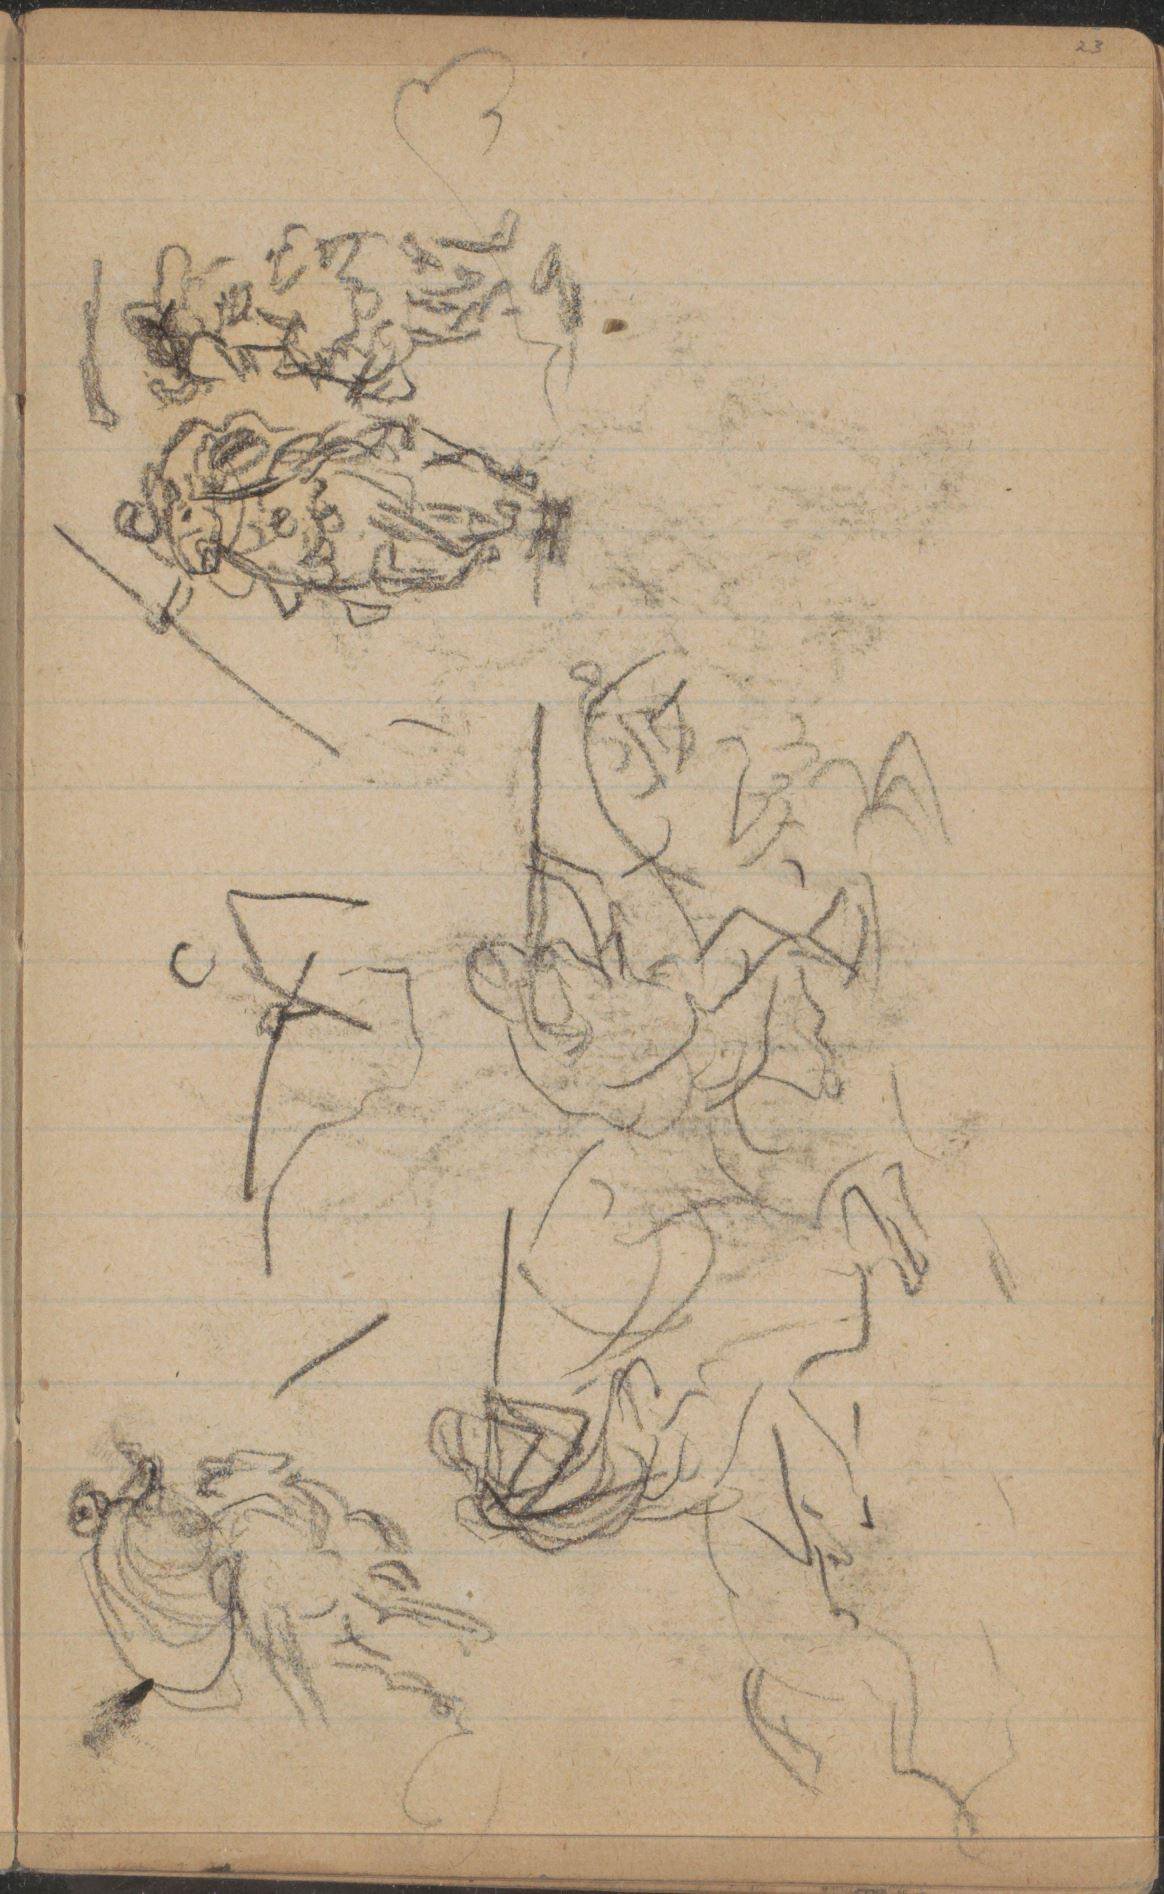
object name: sketchbook leaf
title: Ruiters met stokken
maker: marius bauer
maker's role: draughtsman, print maker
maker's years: 1867-1932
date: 1894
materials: chalk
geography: egypt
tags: riding a horse, ass, or mule; rider, horseman, africans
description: Twee ruiters maken een aanvallende beweging met de stokken. Pagina 23 uit een schetsboek met 48 bladen.